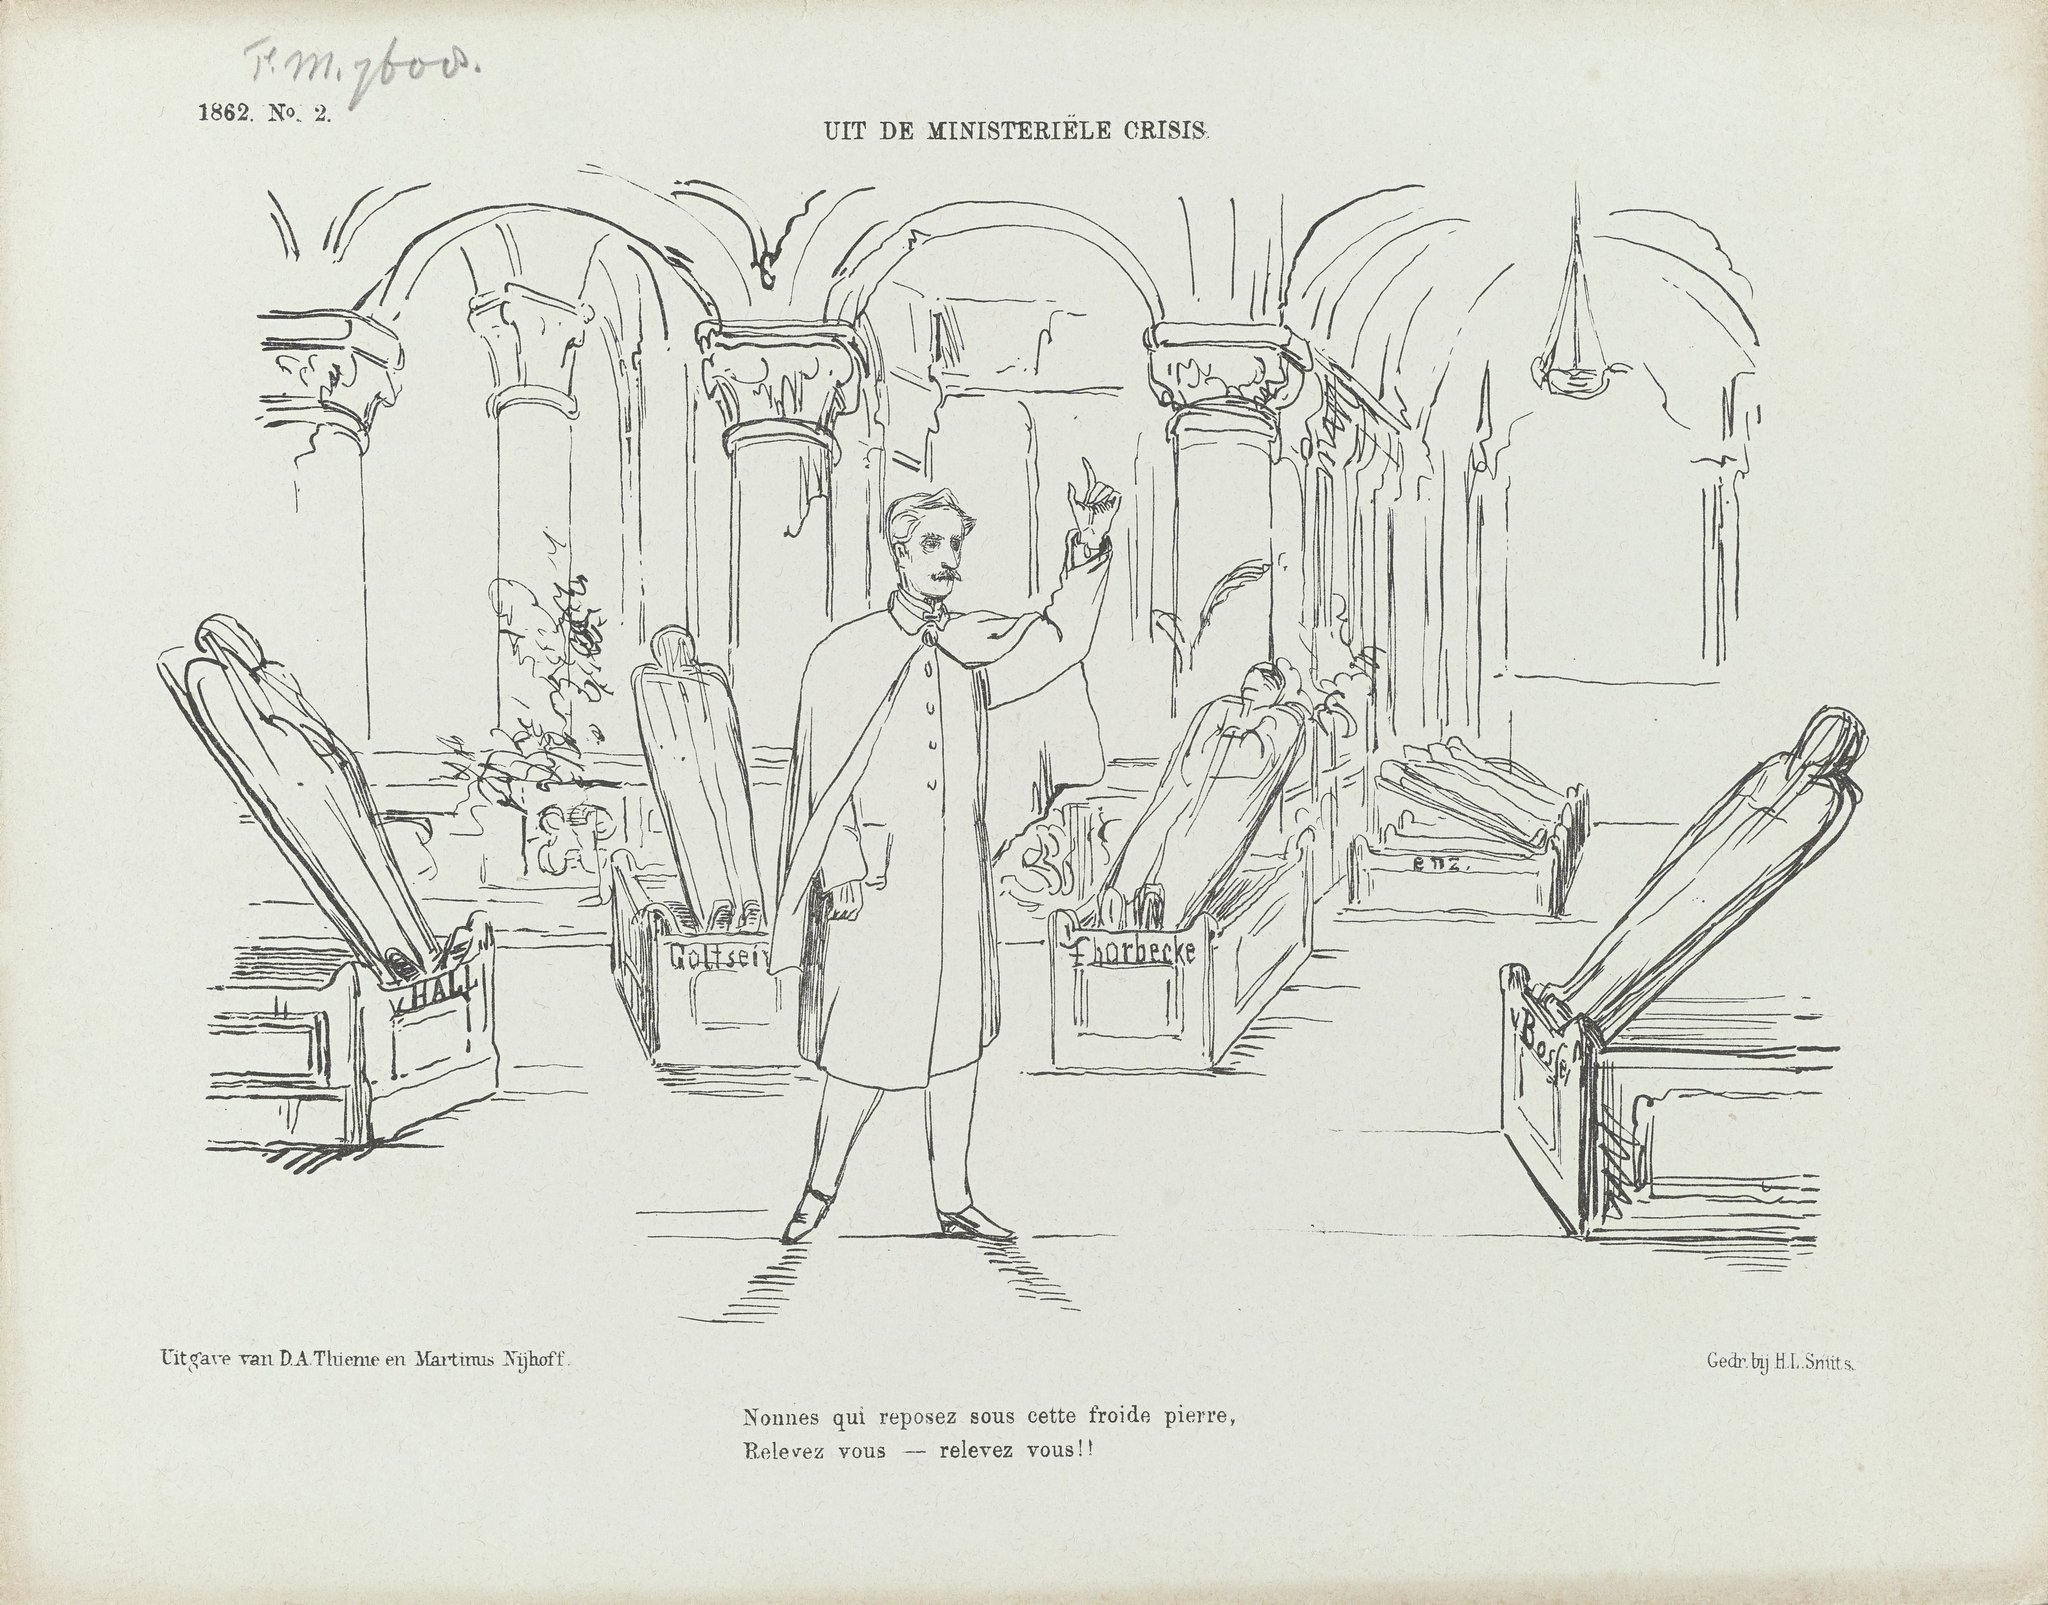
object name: cartoon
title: Spotprent op de ministeriële crisis, 1862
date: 1862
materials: paper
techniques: lithograph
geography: netherlands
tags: johan rudolf thorbecke, amsterdam, floris adriaan van hall, raising from the dead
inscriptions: collector's mark: Lugt 2228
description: Spotprent op de ministeriële crisis begin 1862. De secretaris van het Kabinet van de Koning, De Kock, roept als in de opera 'Robert le Diable' de afgetreden ministers uit hun graven op. Plaat verschenen bij het weekblad De Nederlandsche Spectator, nr. 2, 11 januari 1862.